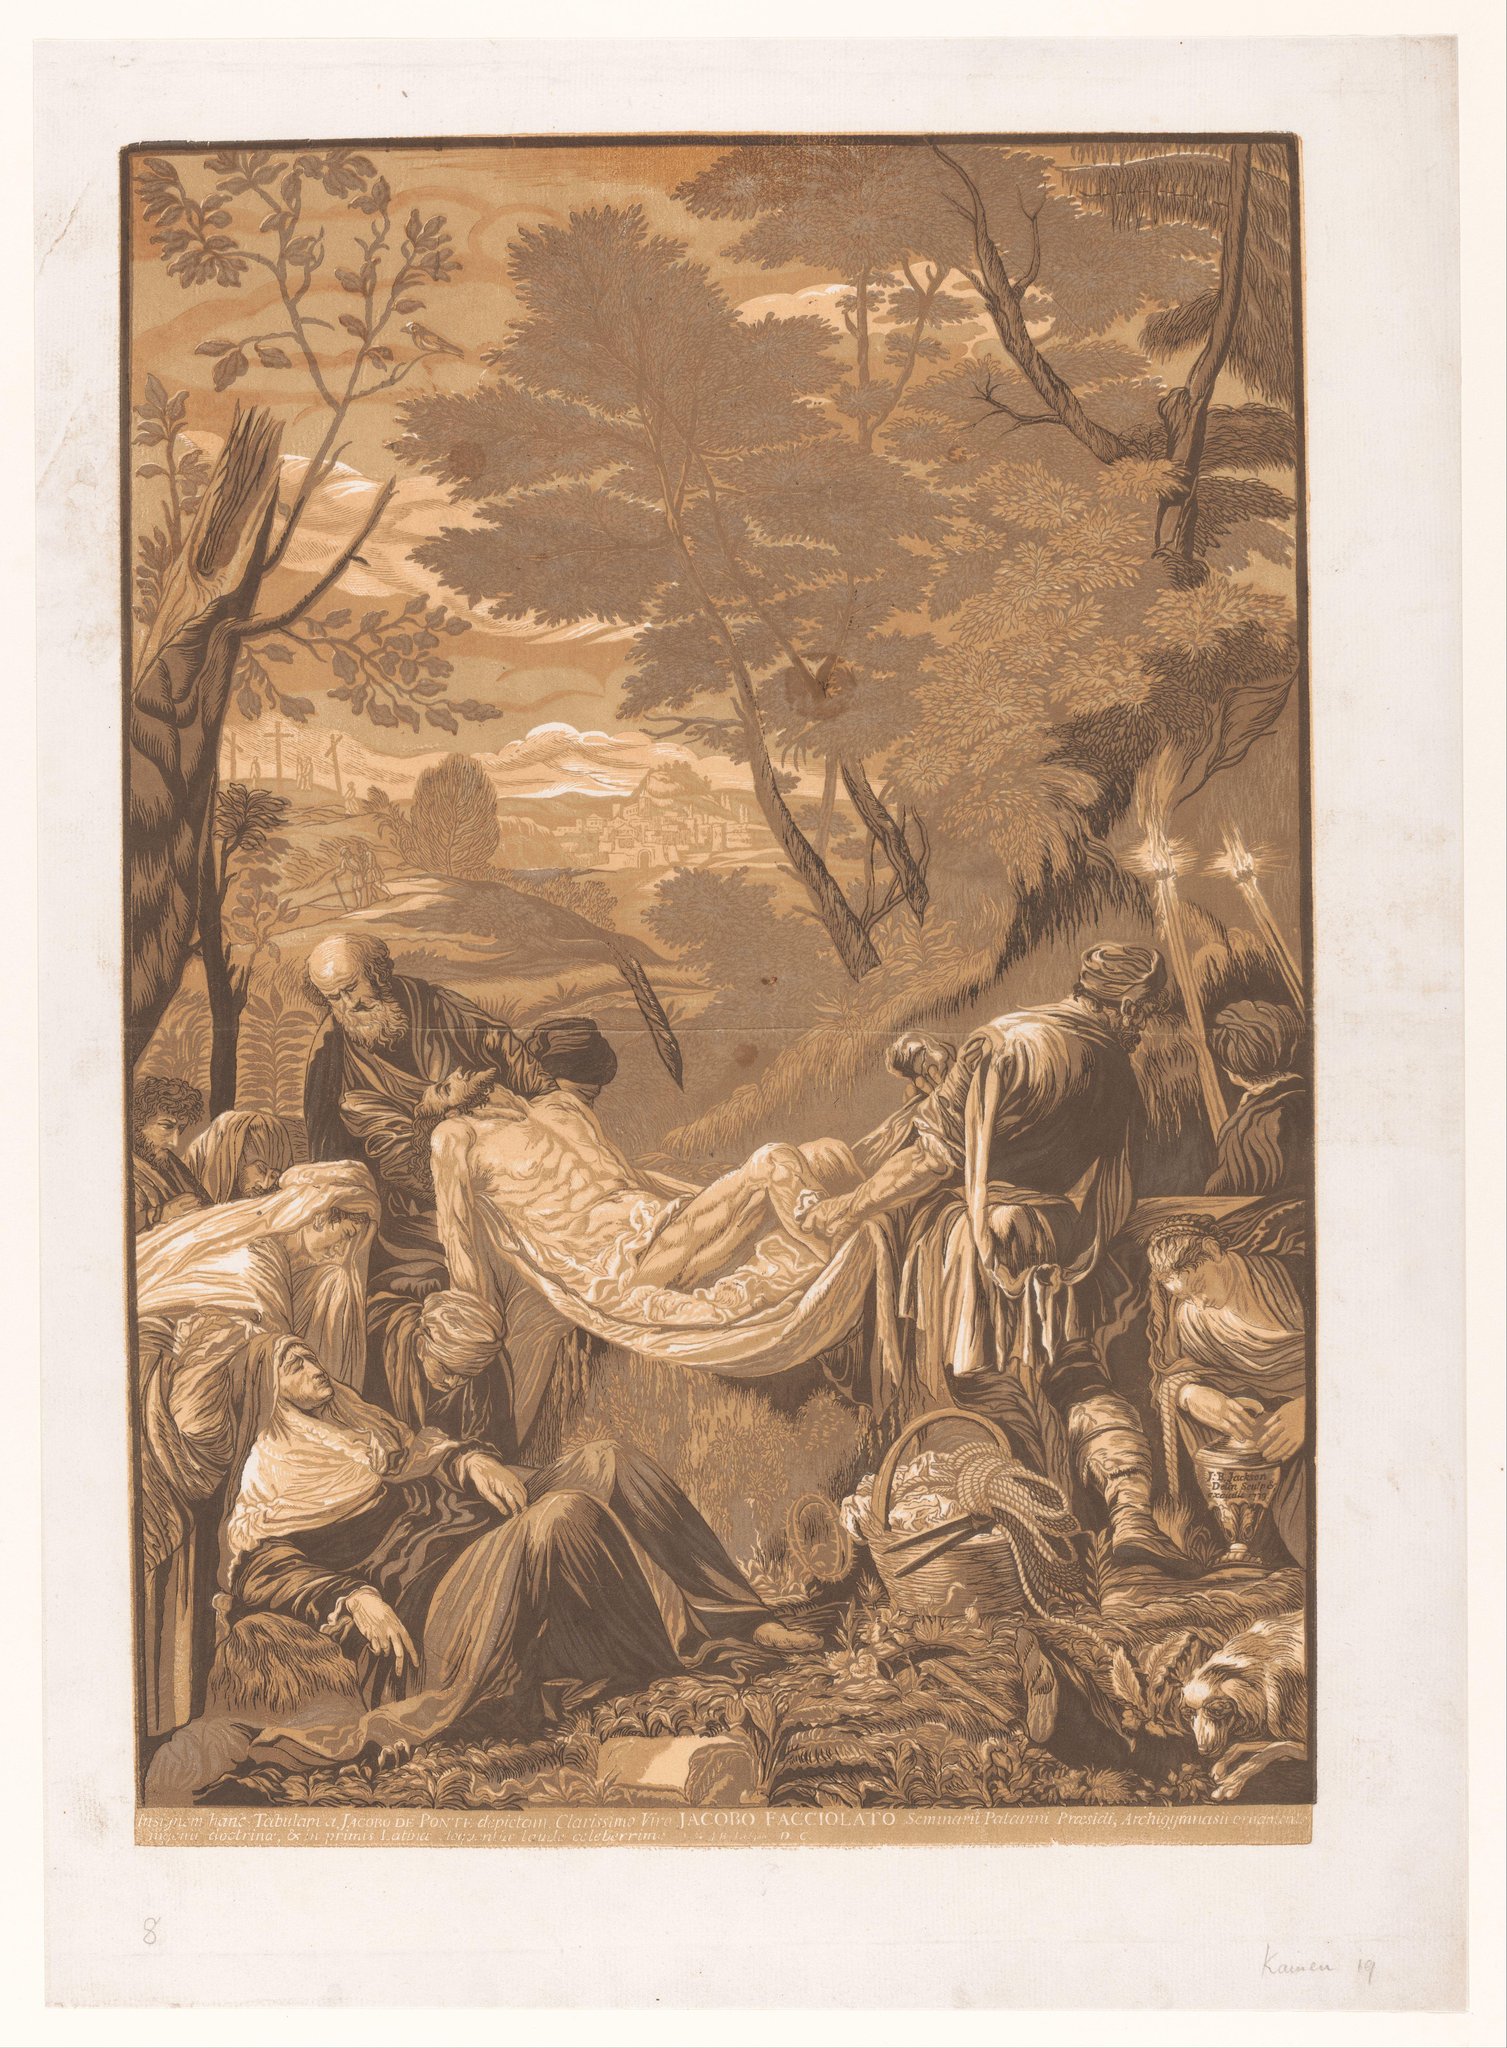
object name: print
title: Graflegging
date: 1745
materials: paper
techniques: woodcut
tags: christ's entombment (possibly by angels)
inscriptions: collector's mark: Lugt 2228, collector's mark: Lugt 2760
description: Prent maakt deel uit van een ongenummerde serie van 24 prenten.